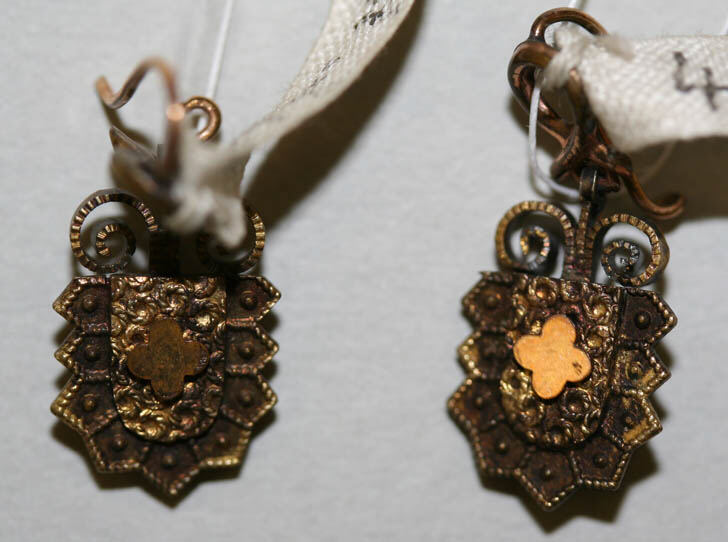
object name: earring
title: Earrings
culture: american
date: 1870-1890